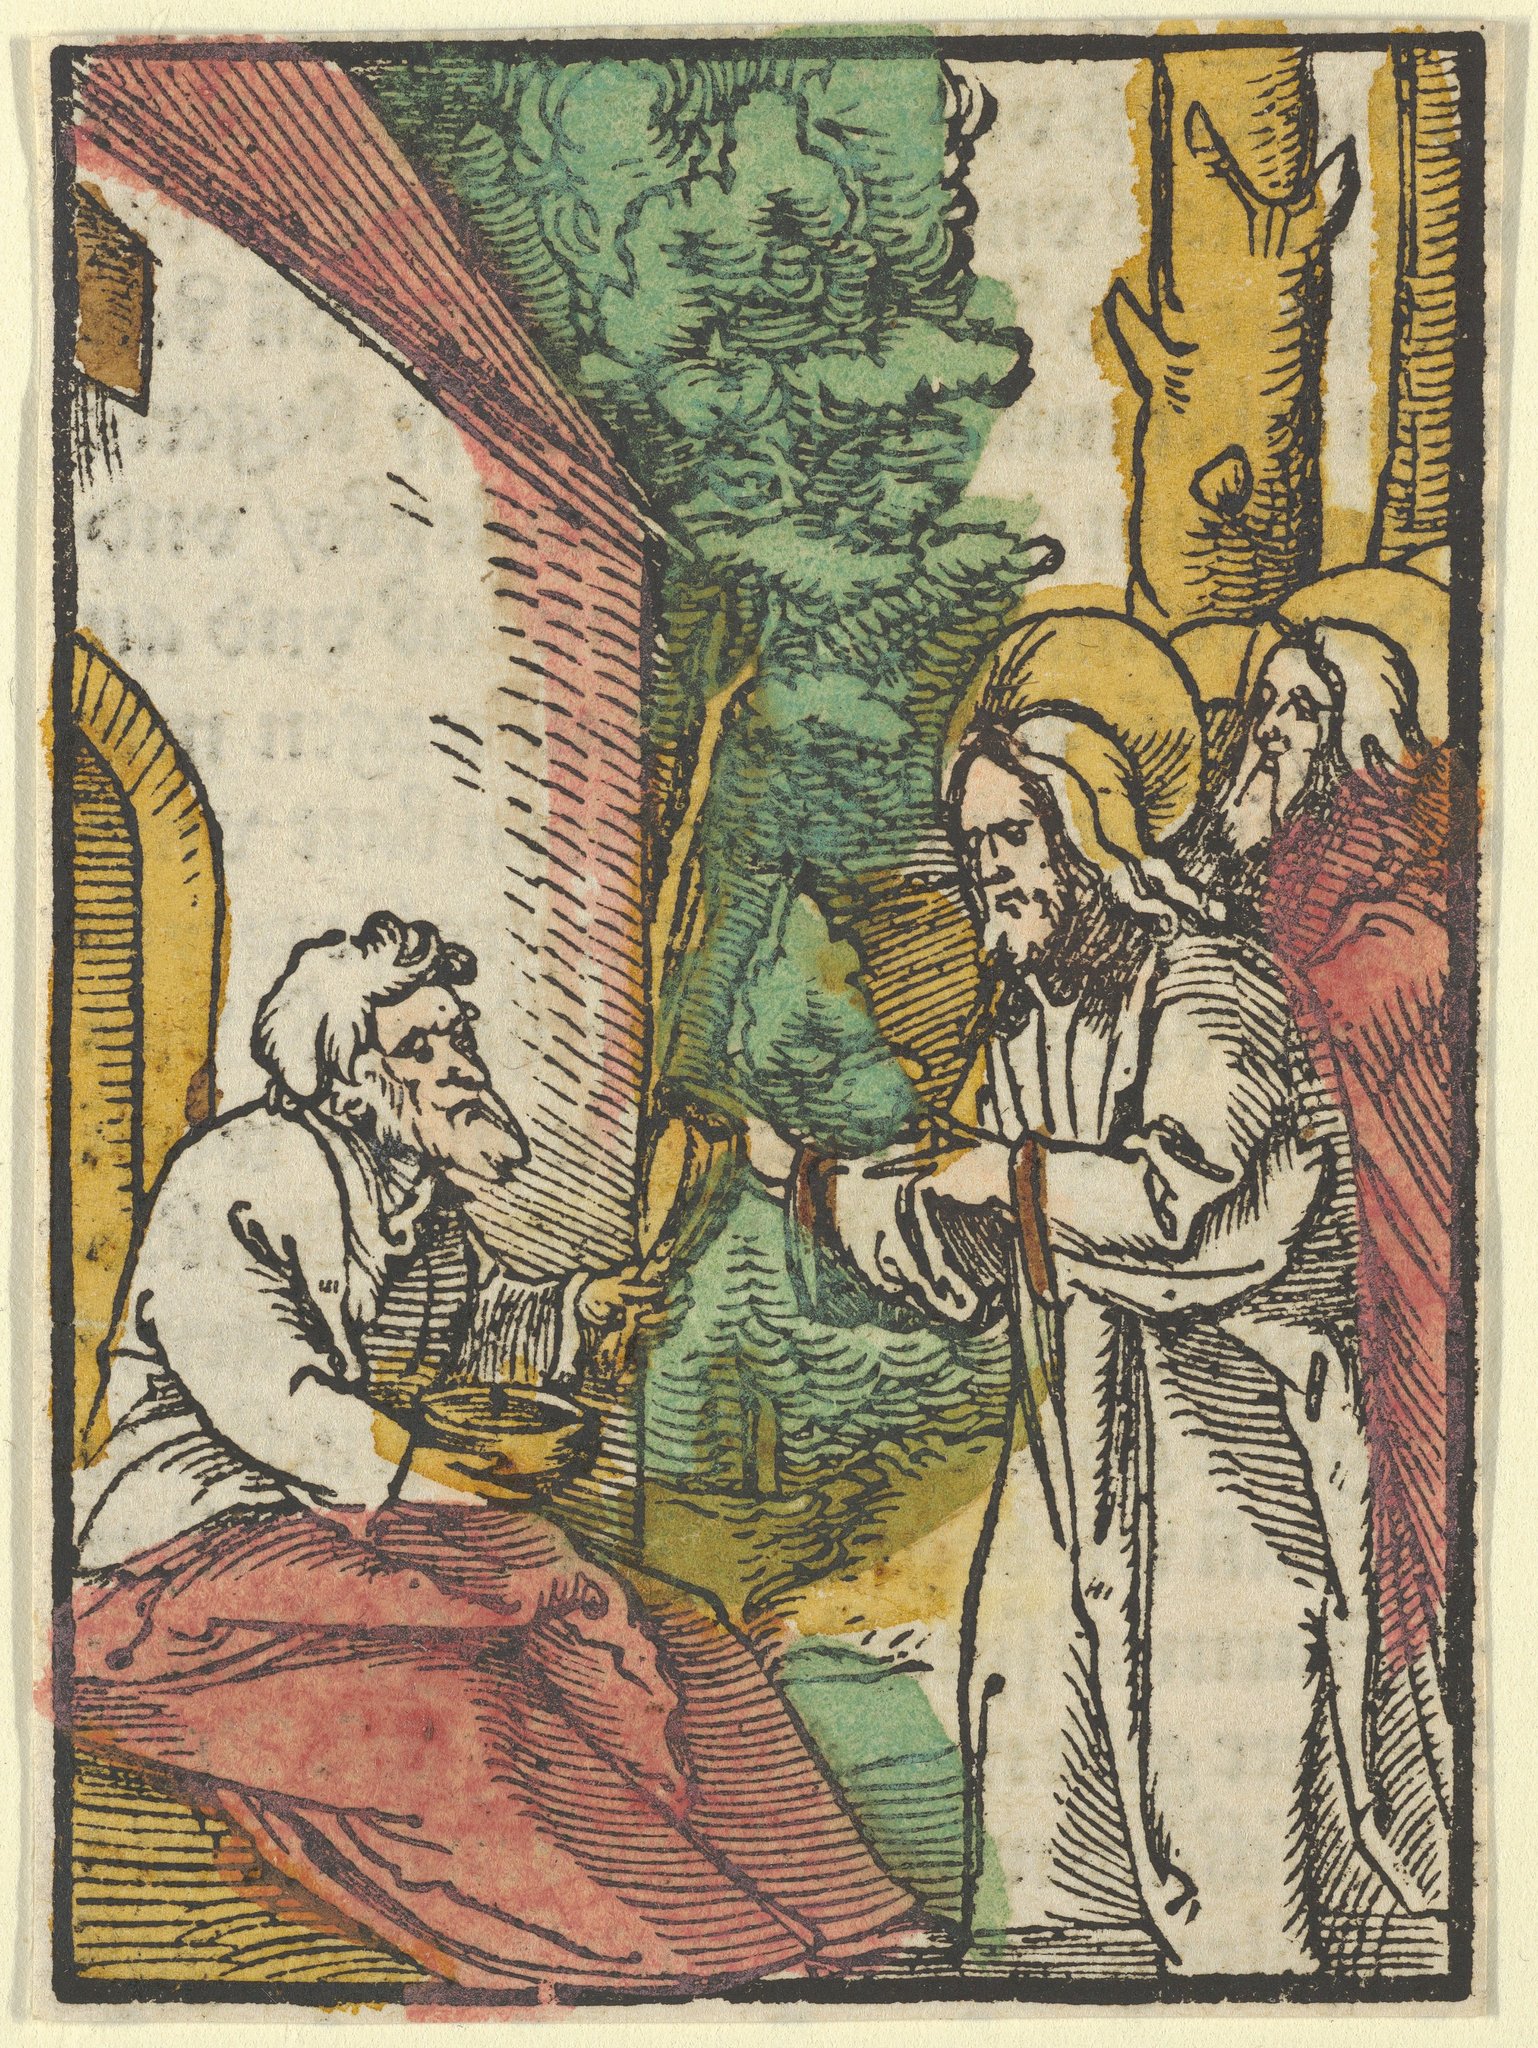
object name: print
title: Christ Healing the Leper, from "Das Plenarium"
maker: hans schäufelein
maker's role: artist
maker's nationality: german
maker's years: 1480-1540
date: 1517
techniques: hand coloring, woodcut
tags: illness,men,christ